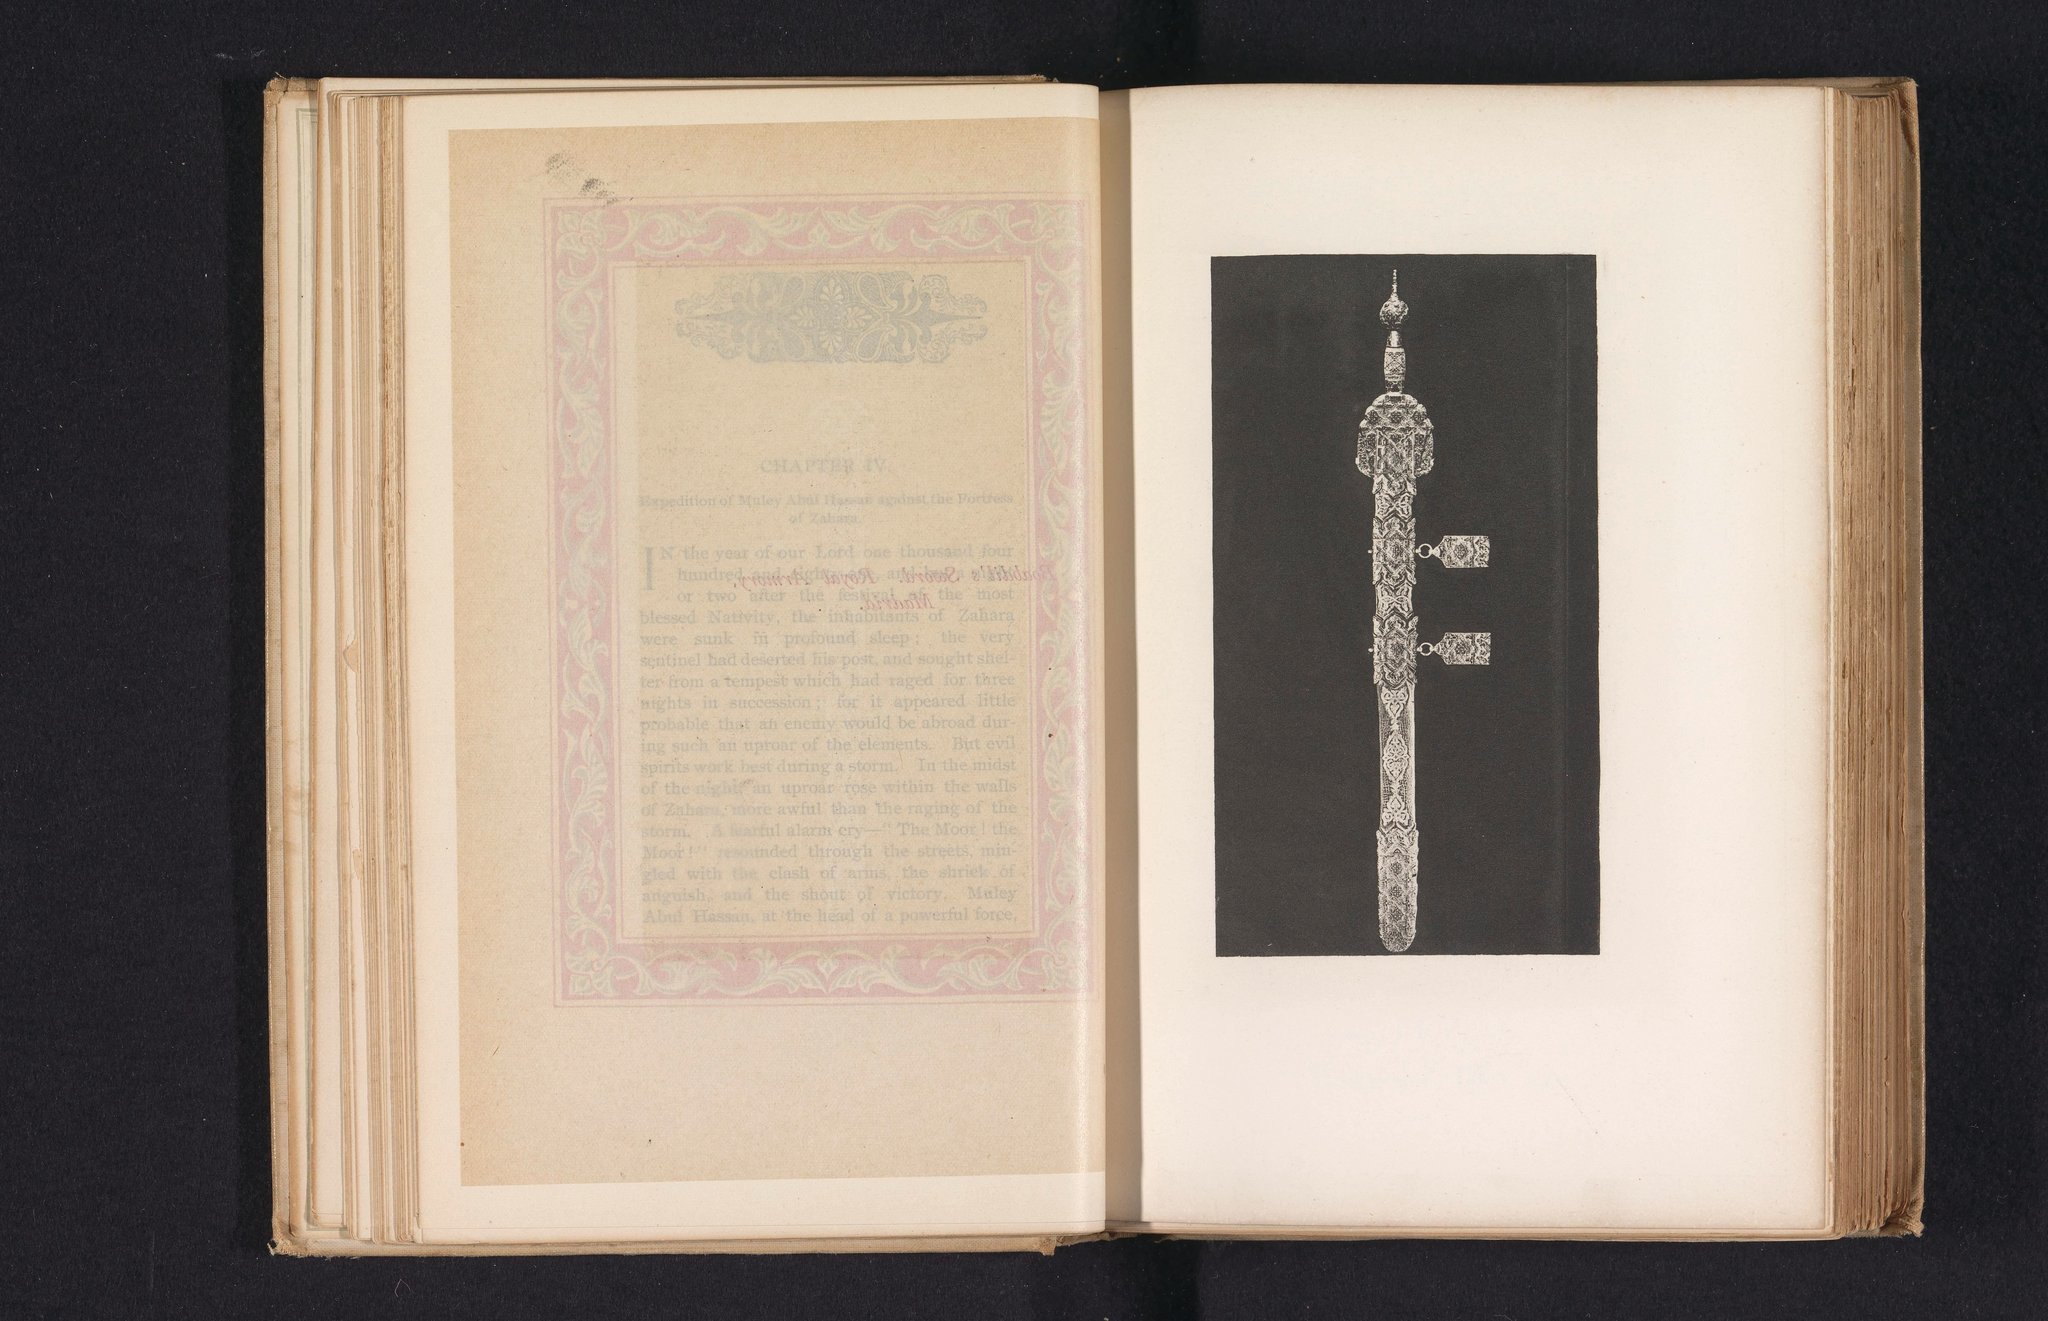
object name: photomechanical print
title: Boabdil's Sword. Royal Armory. Madrid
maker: Anonymous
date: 1883-1893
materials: paper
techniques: photoaquatint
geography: madrid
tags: hacking and thrusting weapons: sword